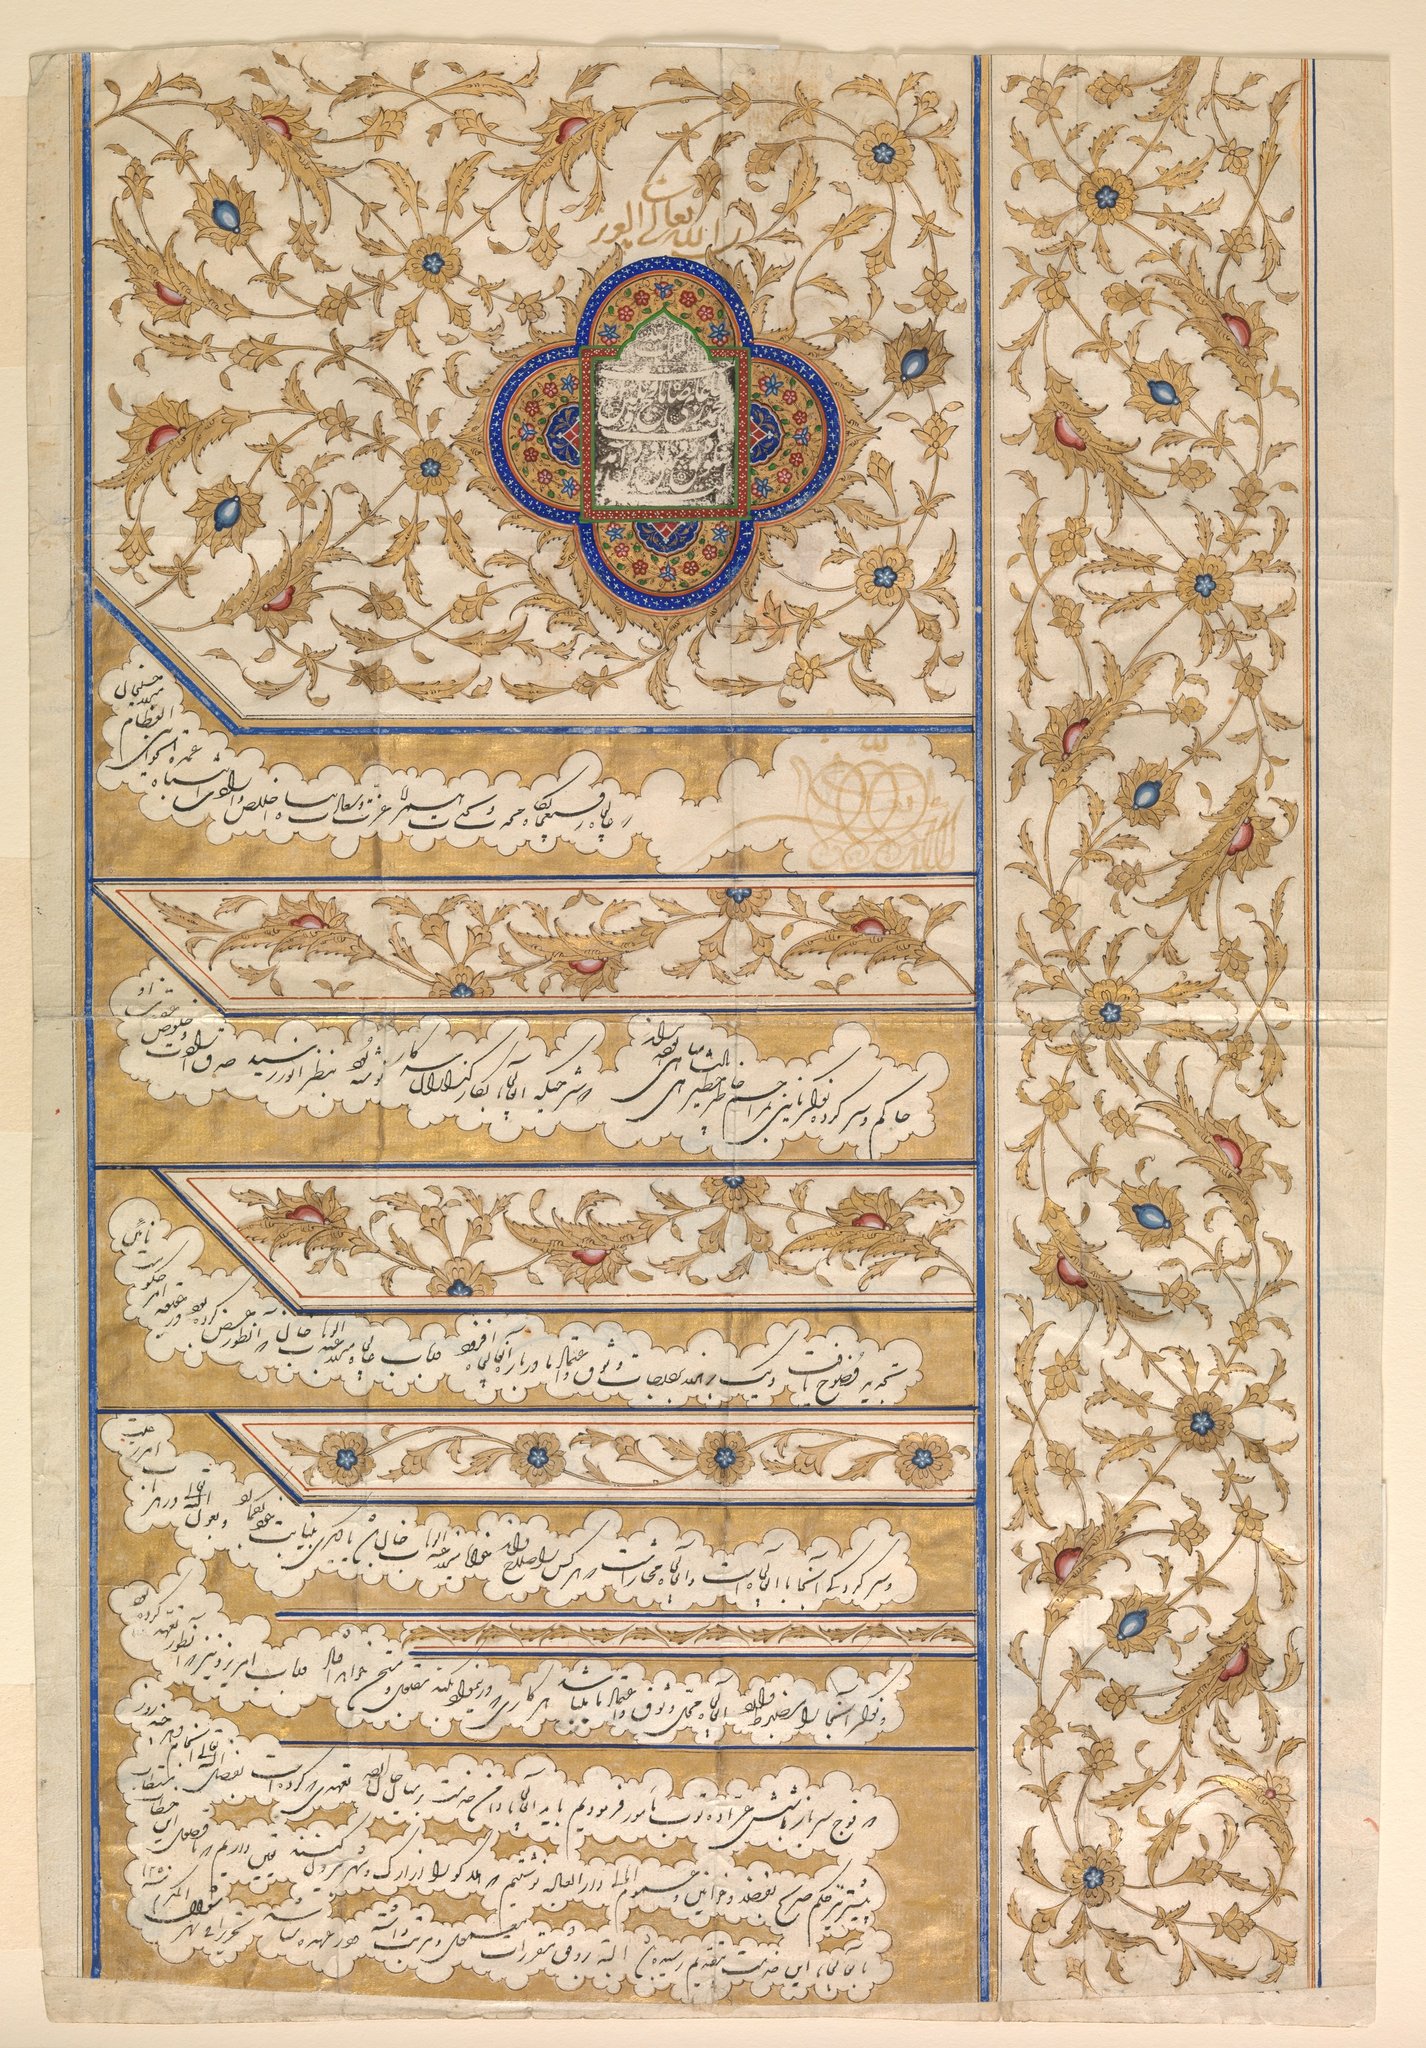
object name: illustrated single work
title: Firman of Muhammad Shah Qajar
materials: gold, ink, paper, watercolor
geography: iran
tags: documents